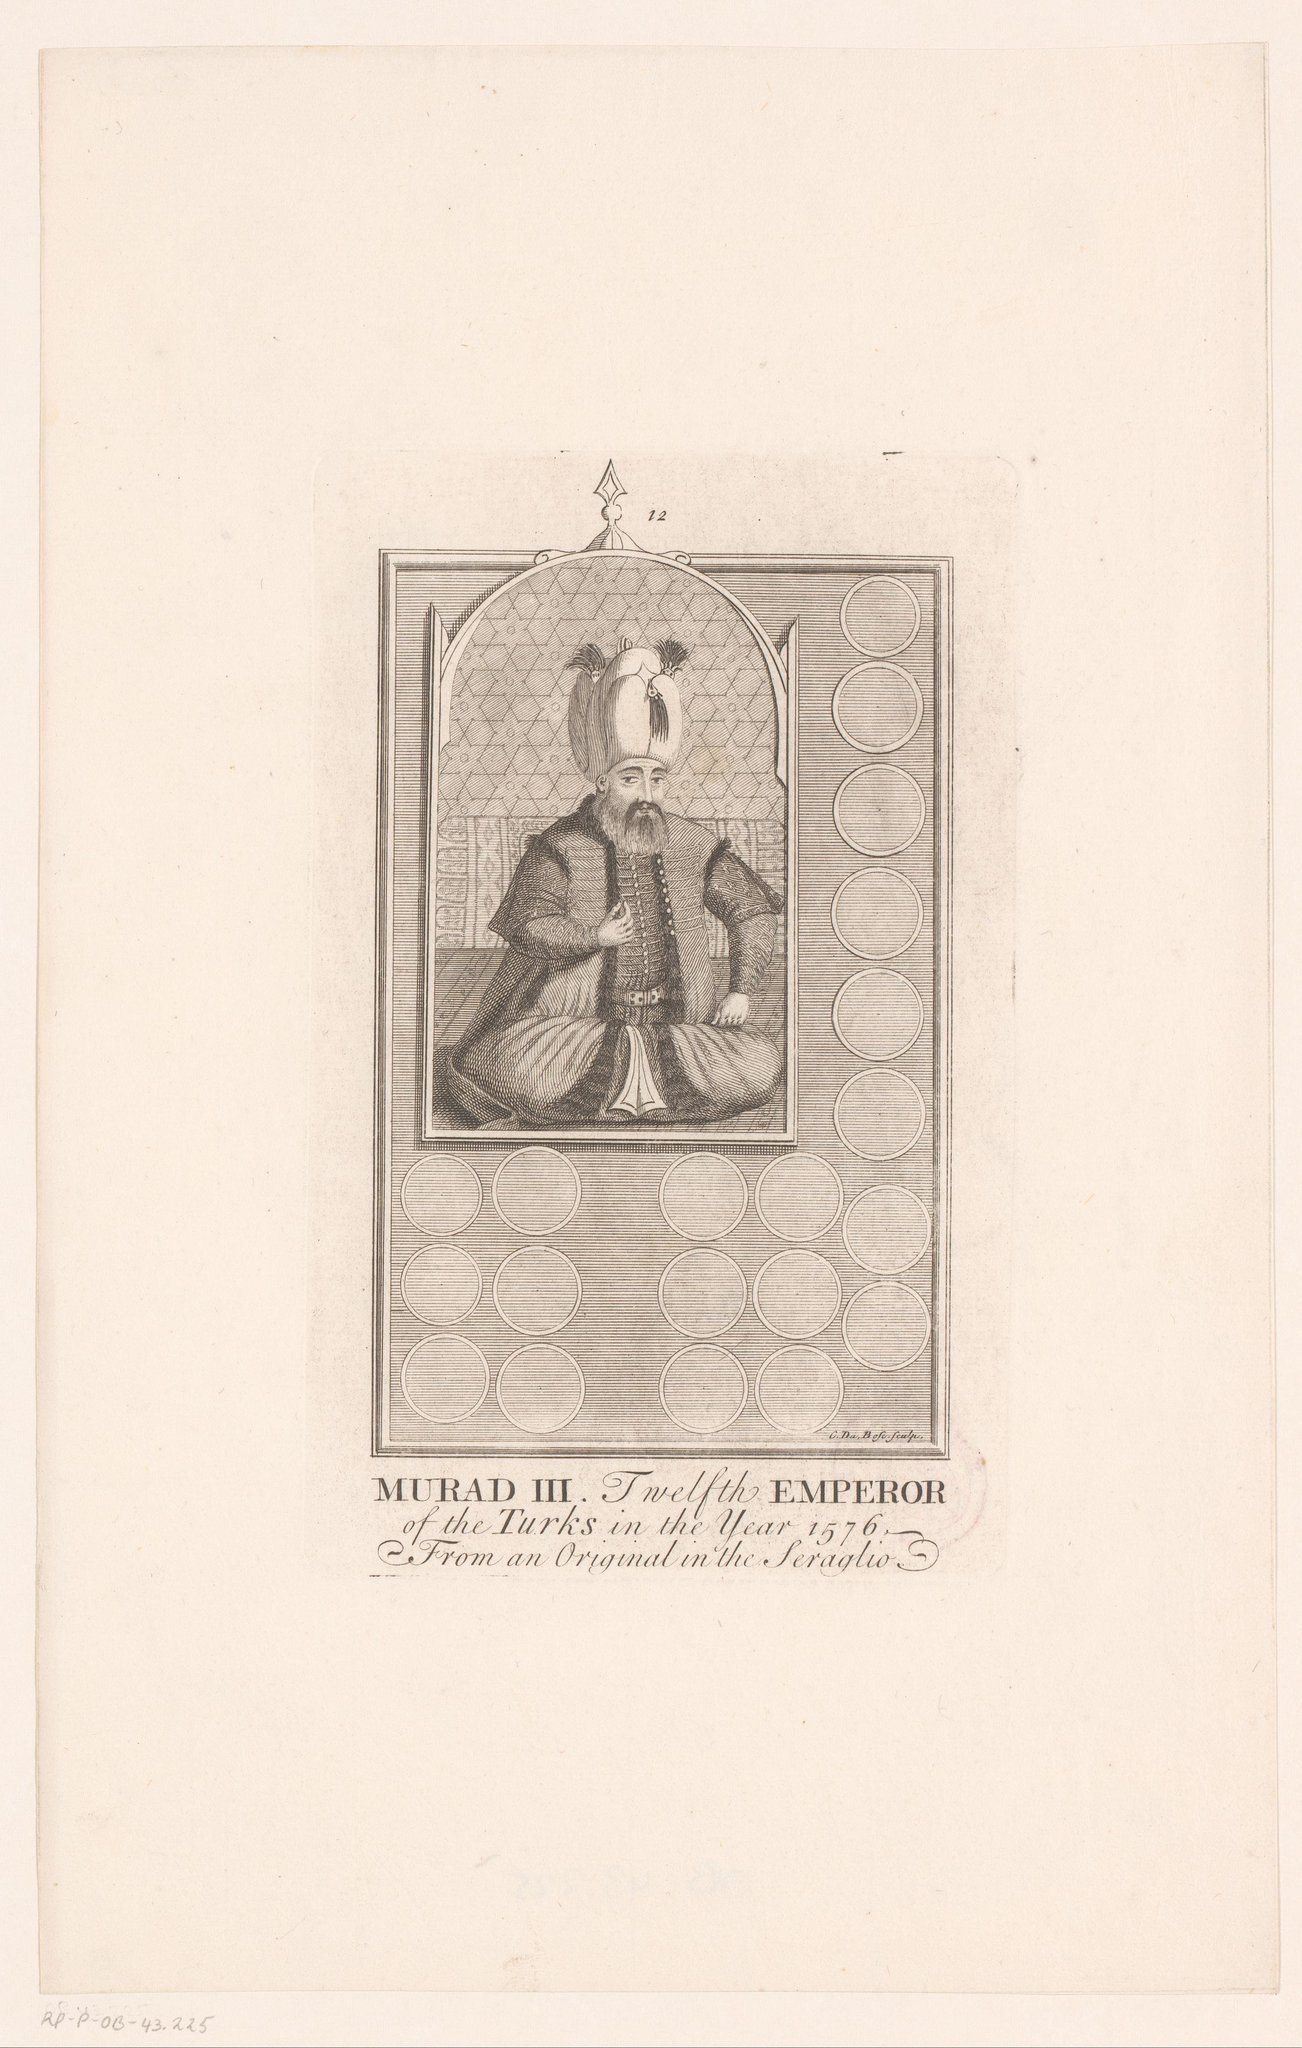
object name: print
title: Murad III.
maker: claude dubosc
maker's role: print maker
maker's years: 1682-1745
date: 1692-1745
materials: paper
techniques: engraving, etching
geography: france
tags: historical persons, ruler, sovereign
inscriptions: collector's mark: Lugt 240